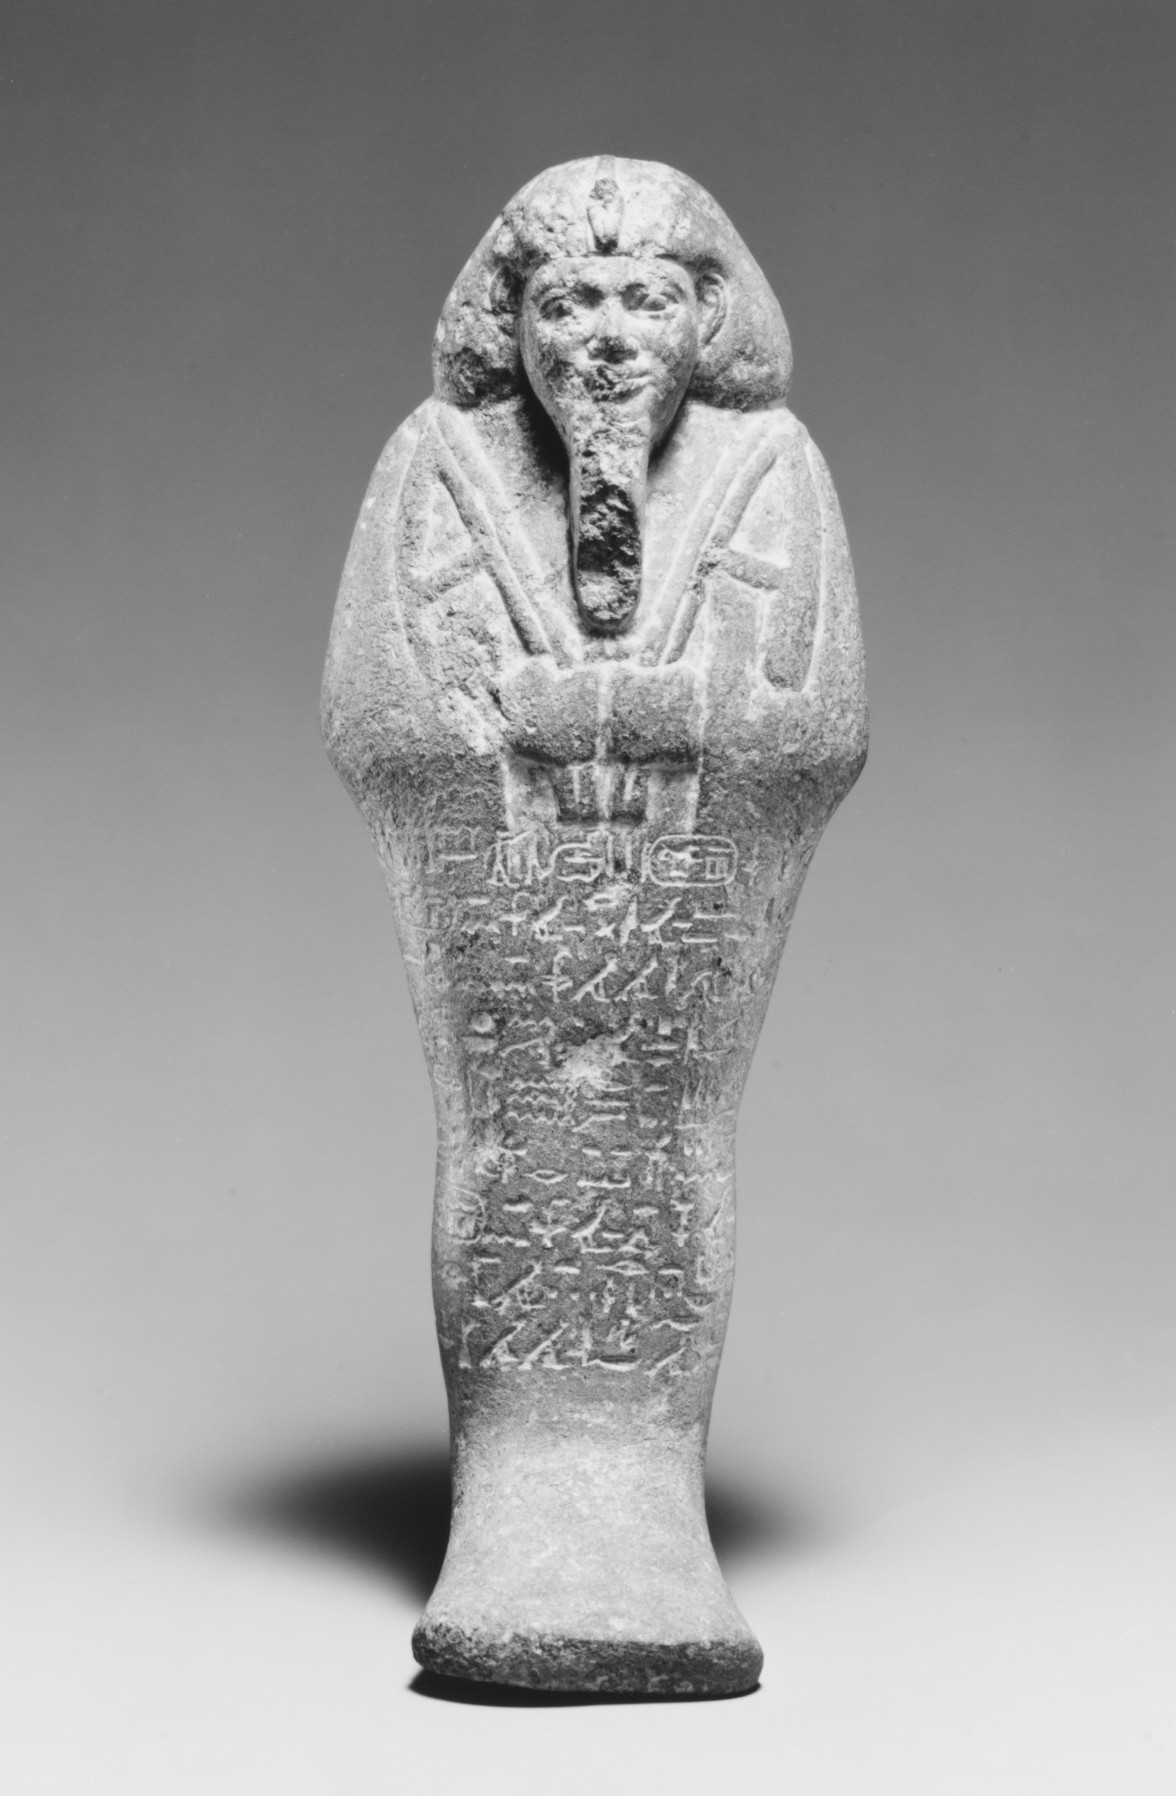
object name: shabti, taharqo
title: Shabti of Taharqo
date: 690-664 BCE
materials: granite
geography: nubia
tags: hieroglyphs